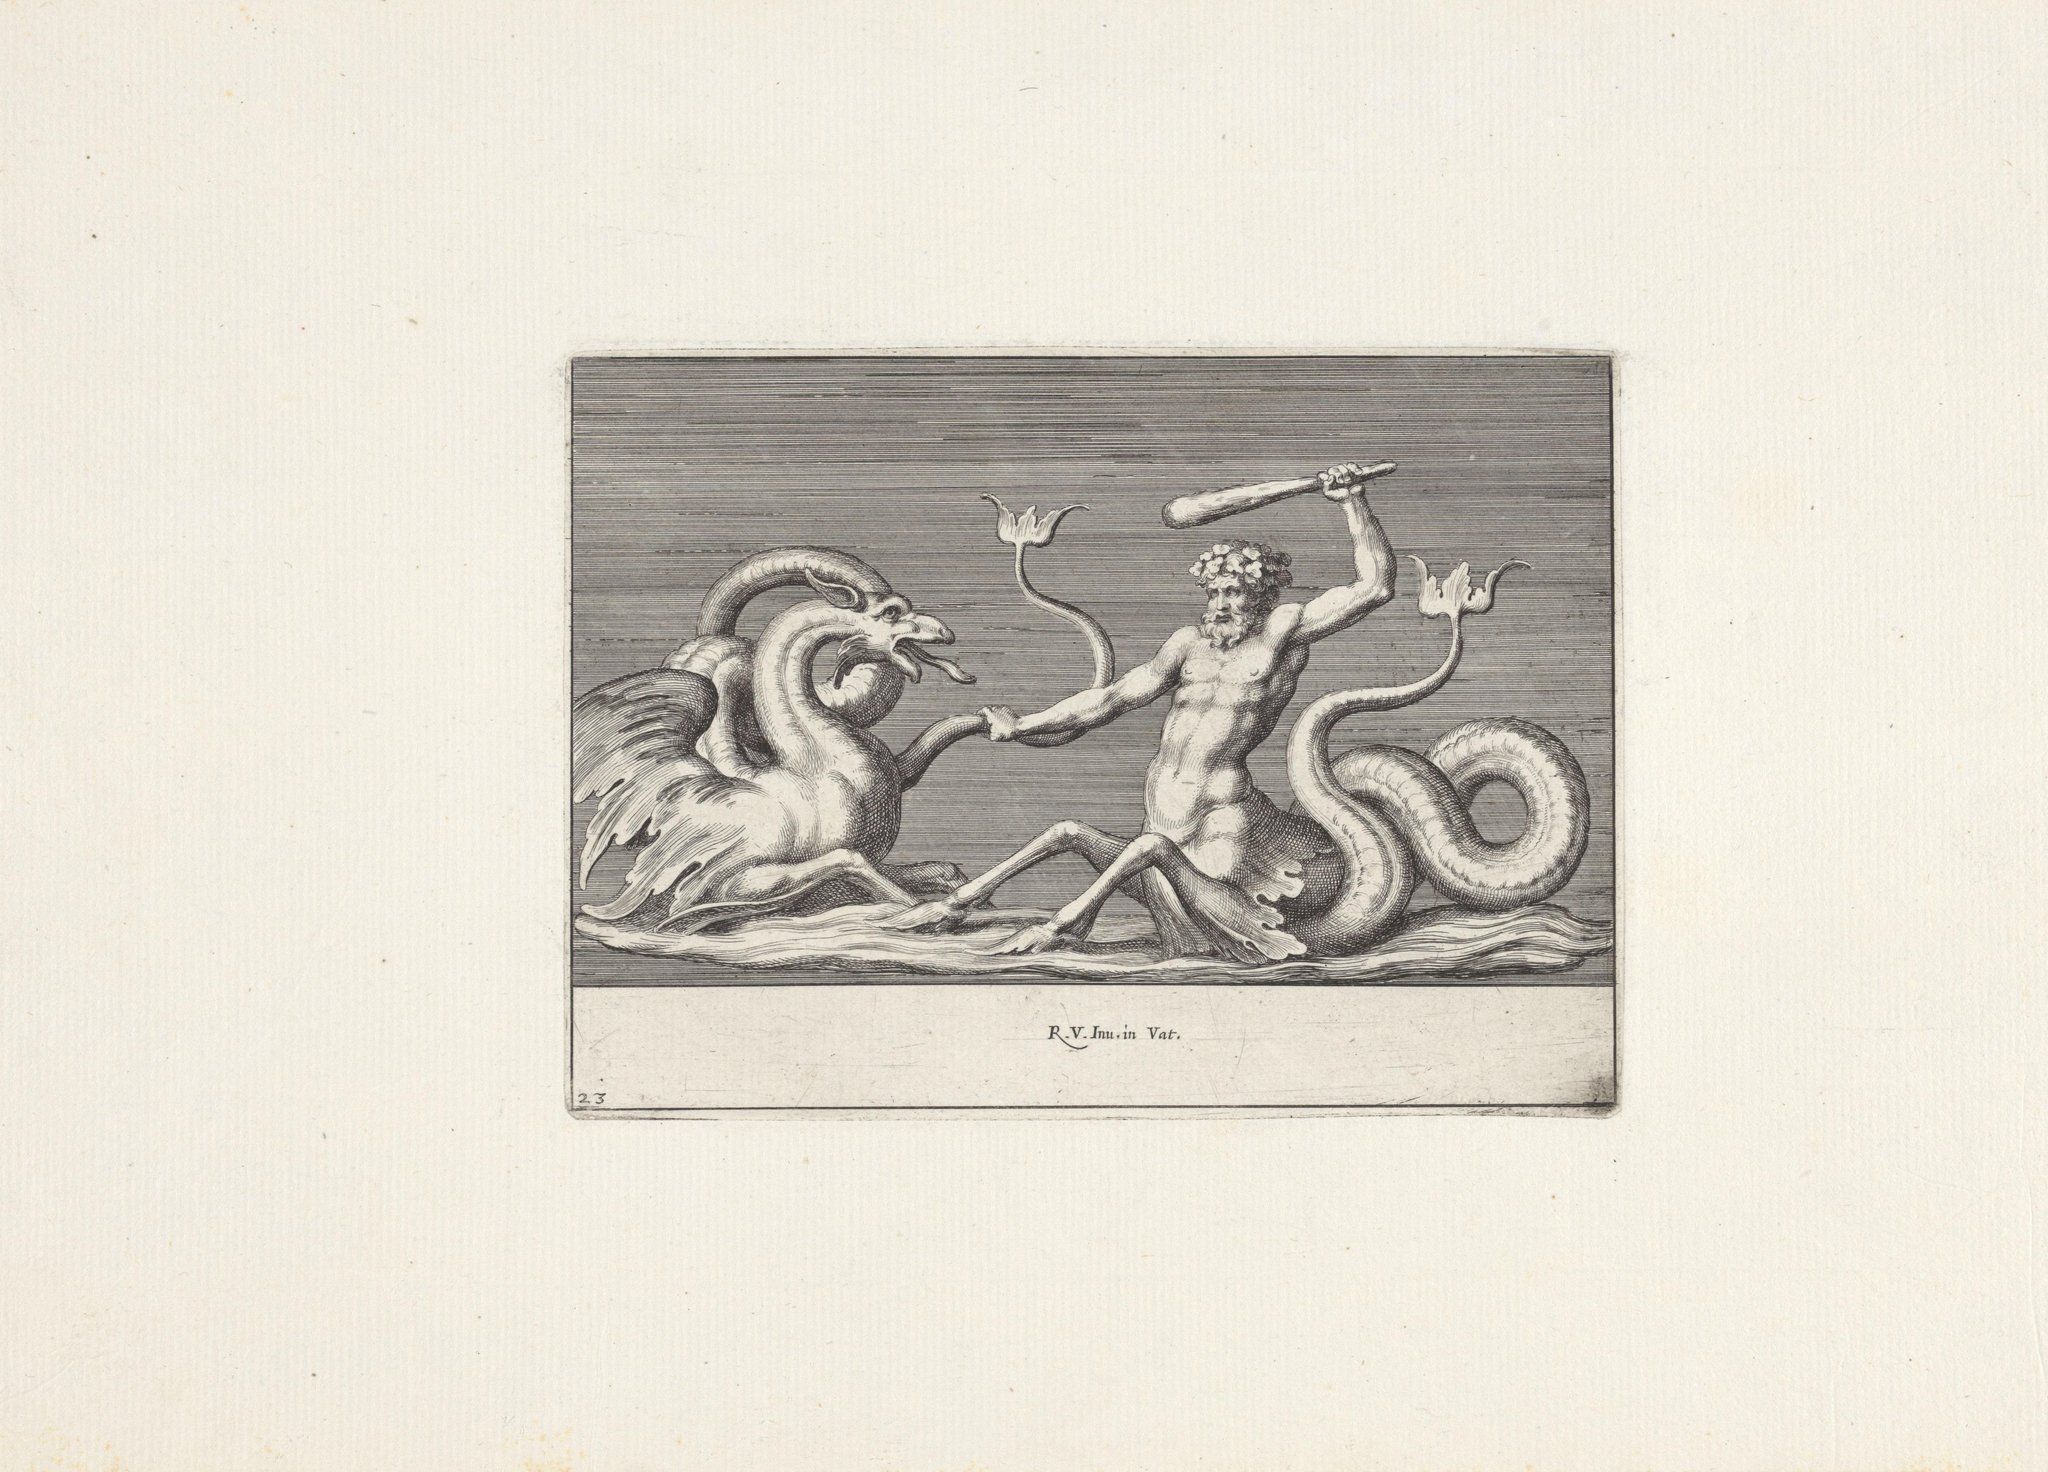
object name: print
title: Triton in gevecht met een zeemonster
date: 1645-1700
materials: paper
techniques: engraving, etching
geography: rome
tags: triton(s), monsters of the sea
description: Prent uit een reeks naar de gipsen reliëfs door Rafaël en uitgevoerd door zijn assistenten in de Vaticaanse Loggia.